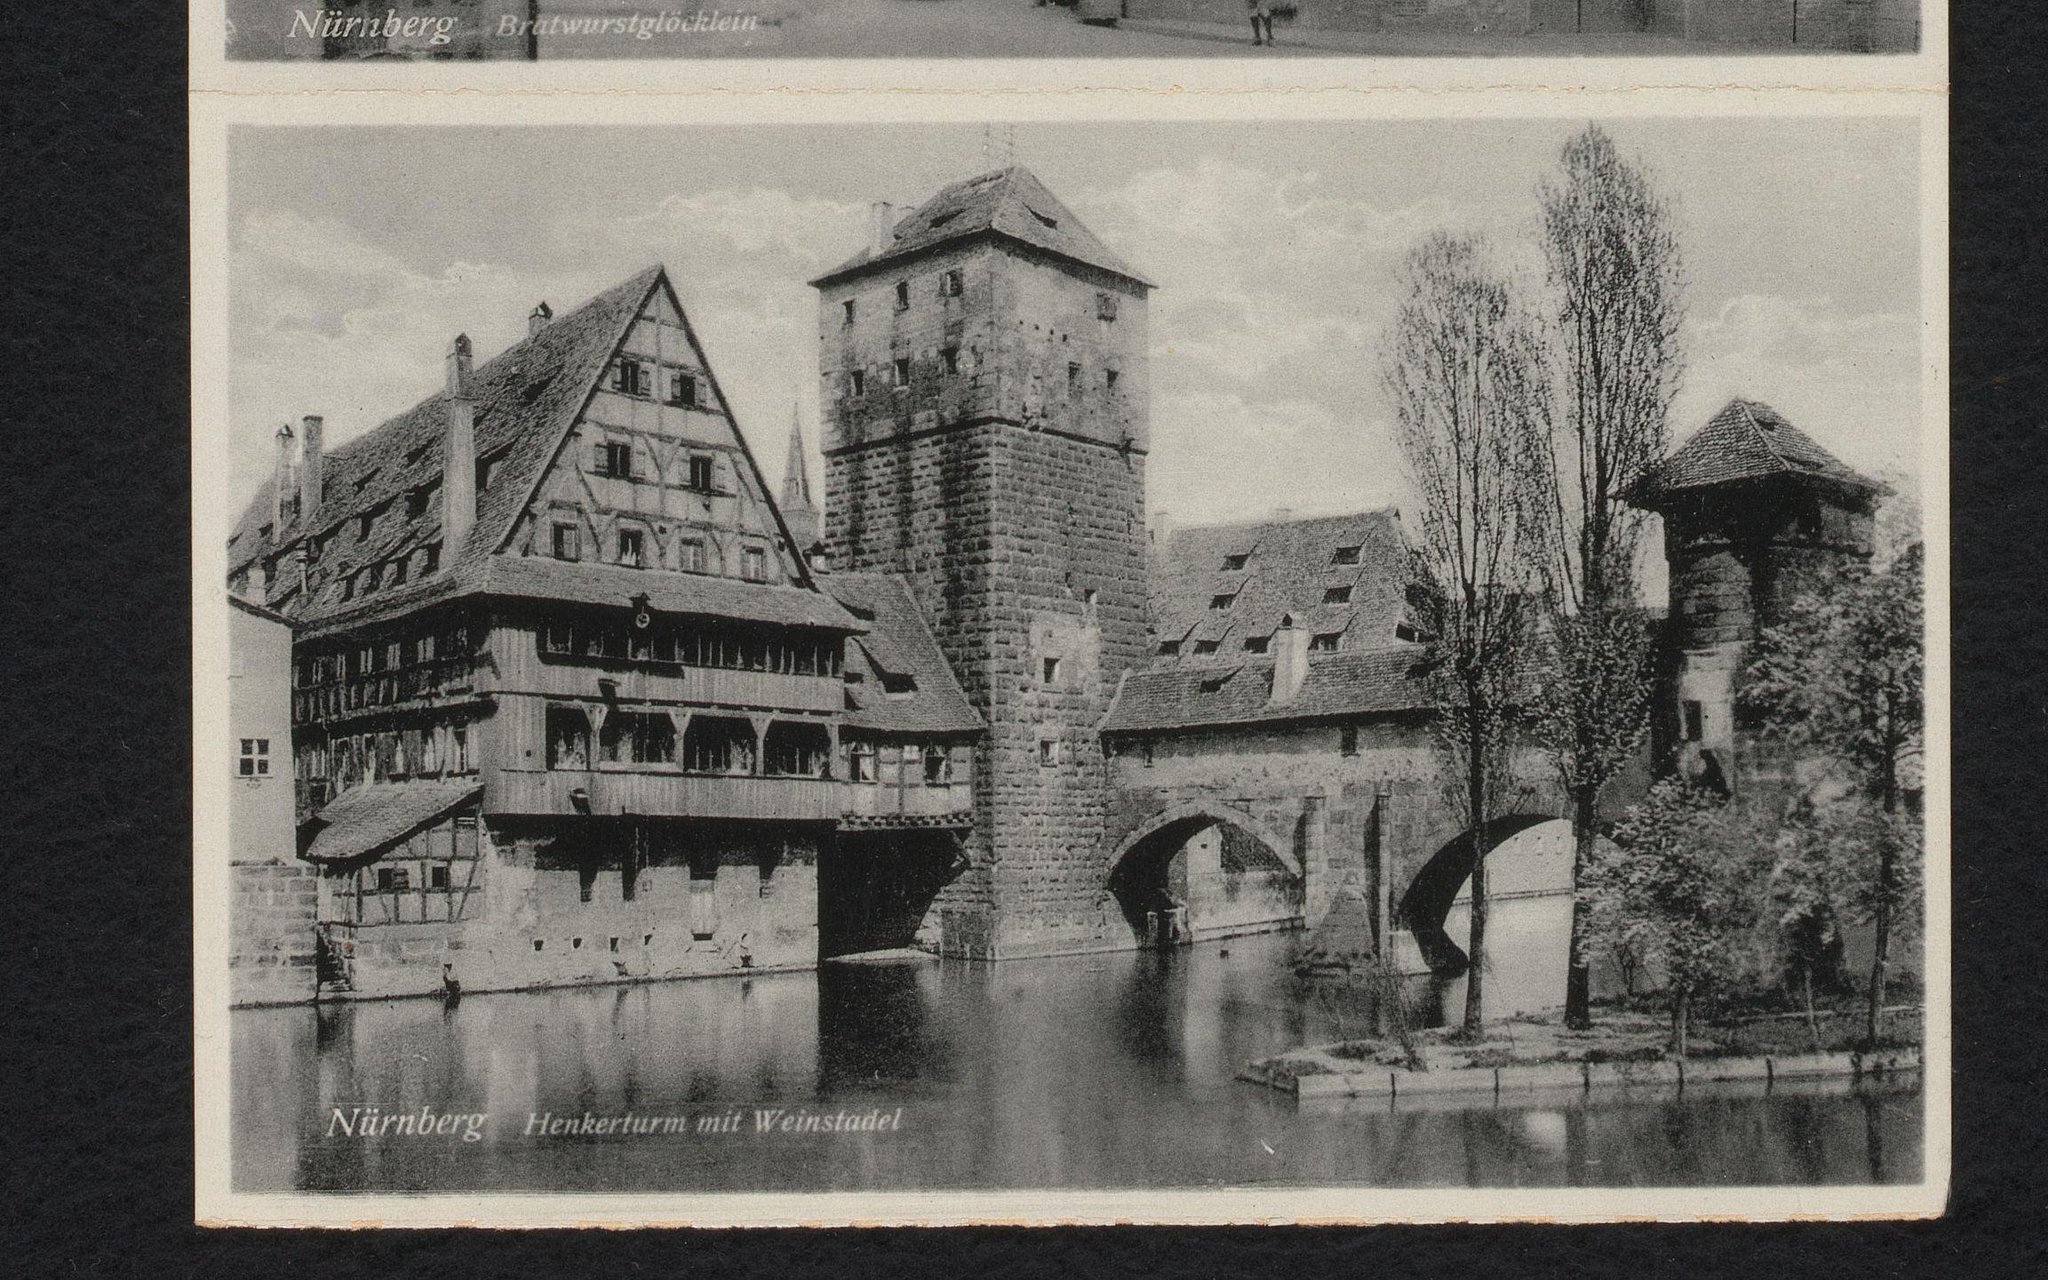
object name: ansichtkaart, prentbriefkaart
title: Nürnberg. Ansicht vom Hallertor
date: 1905-1944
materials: cardboard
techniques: photograph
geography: nuremberg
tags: city-view, and landscape with man-made constructions, castle